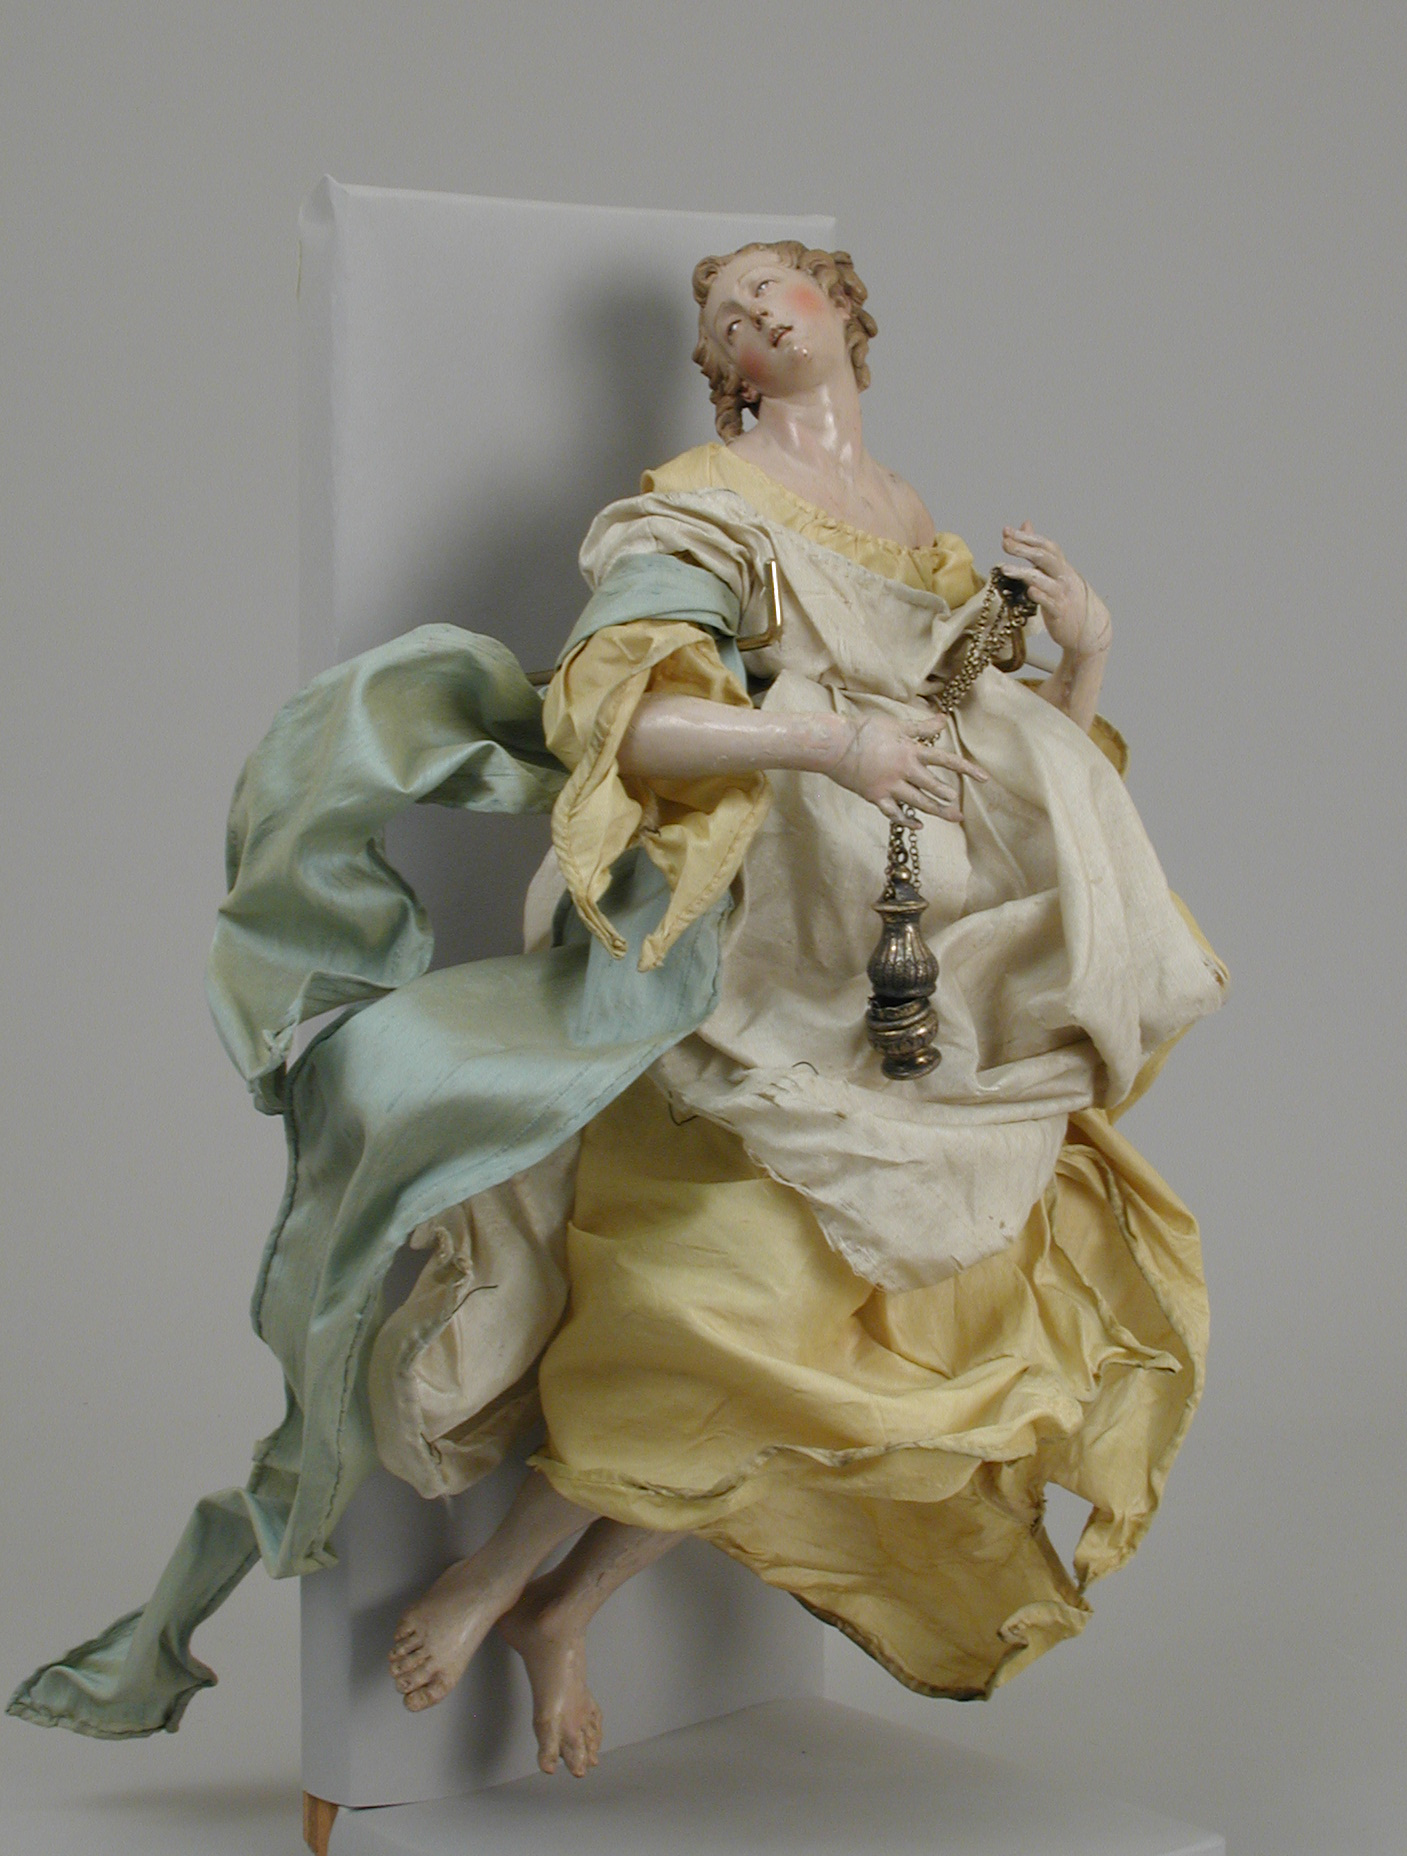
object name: crèche figure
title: Angel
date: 1751-1800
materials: terracotta, fiber, metal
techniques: polychrome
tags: angels